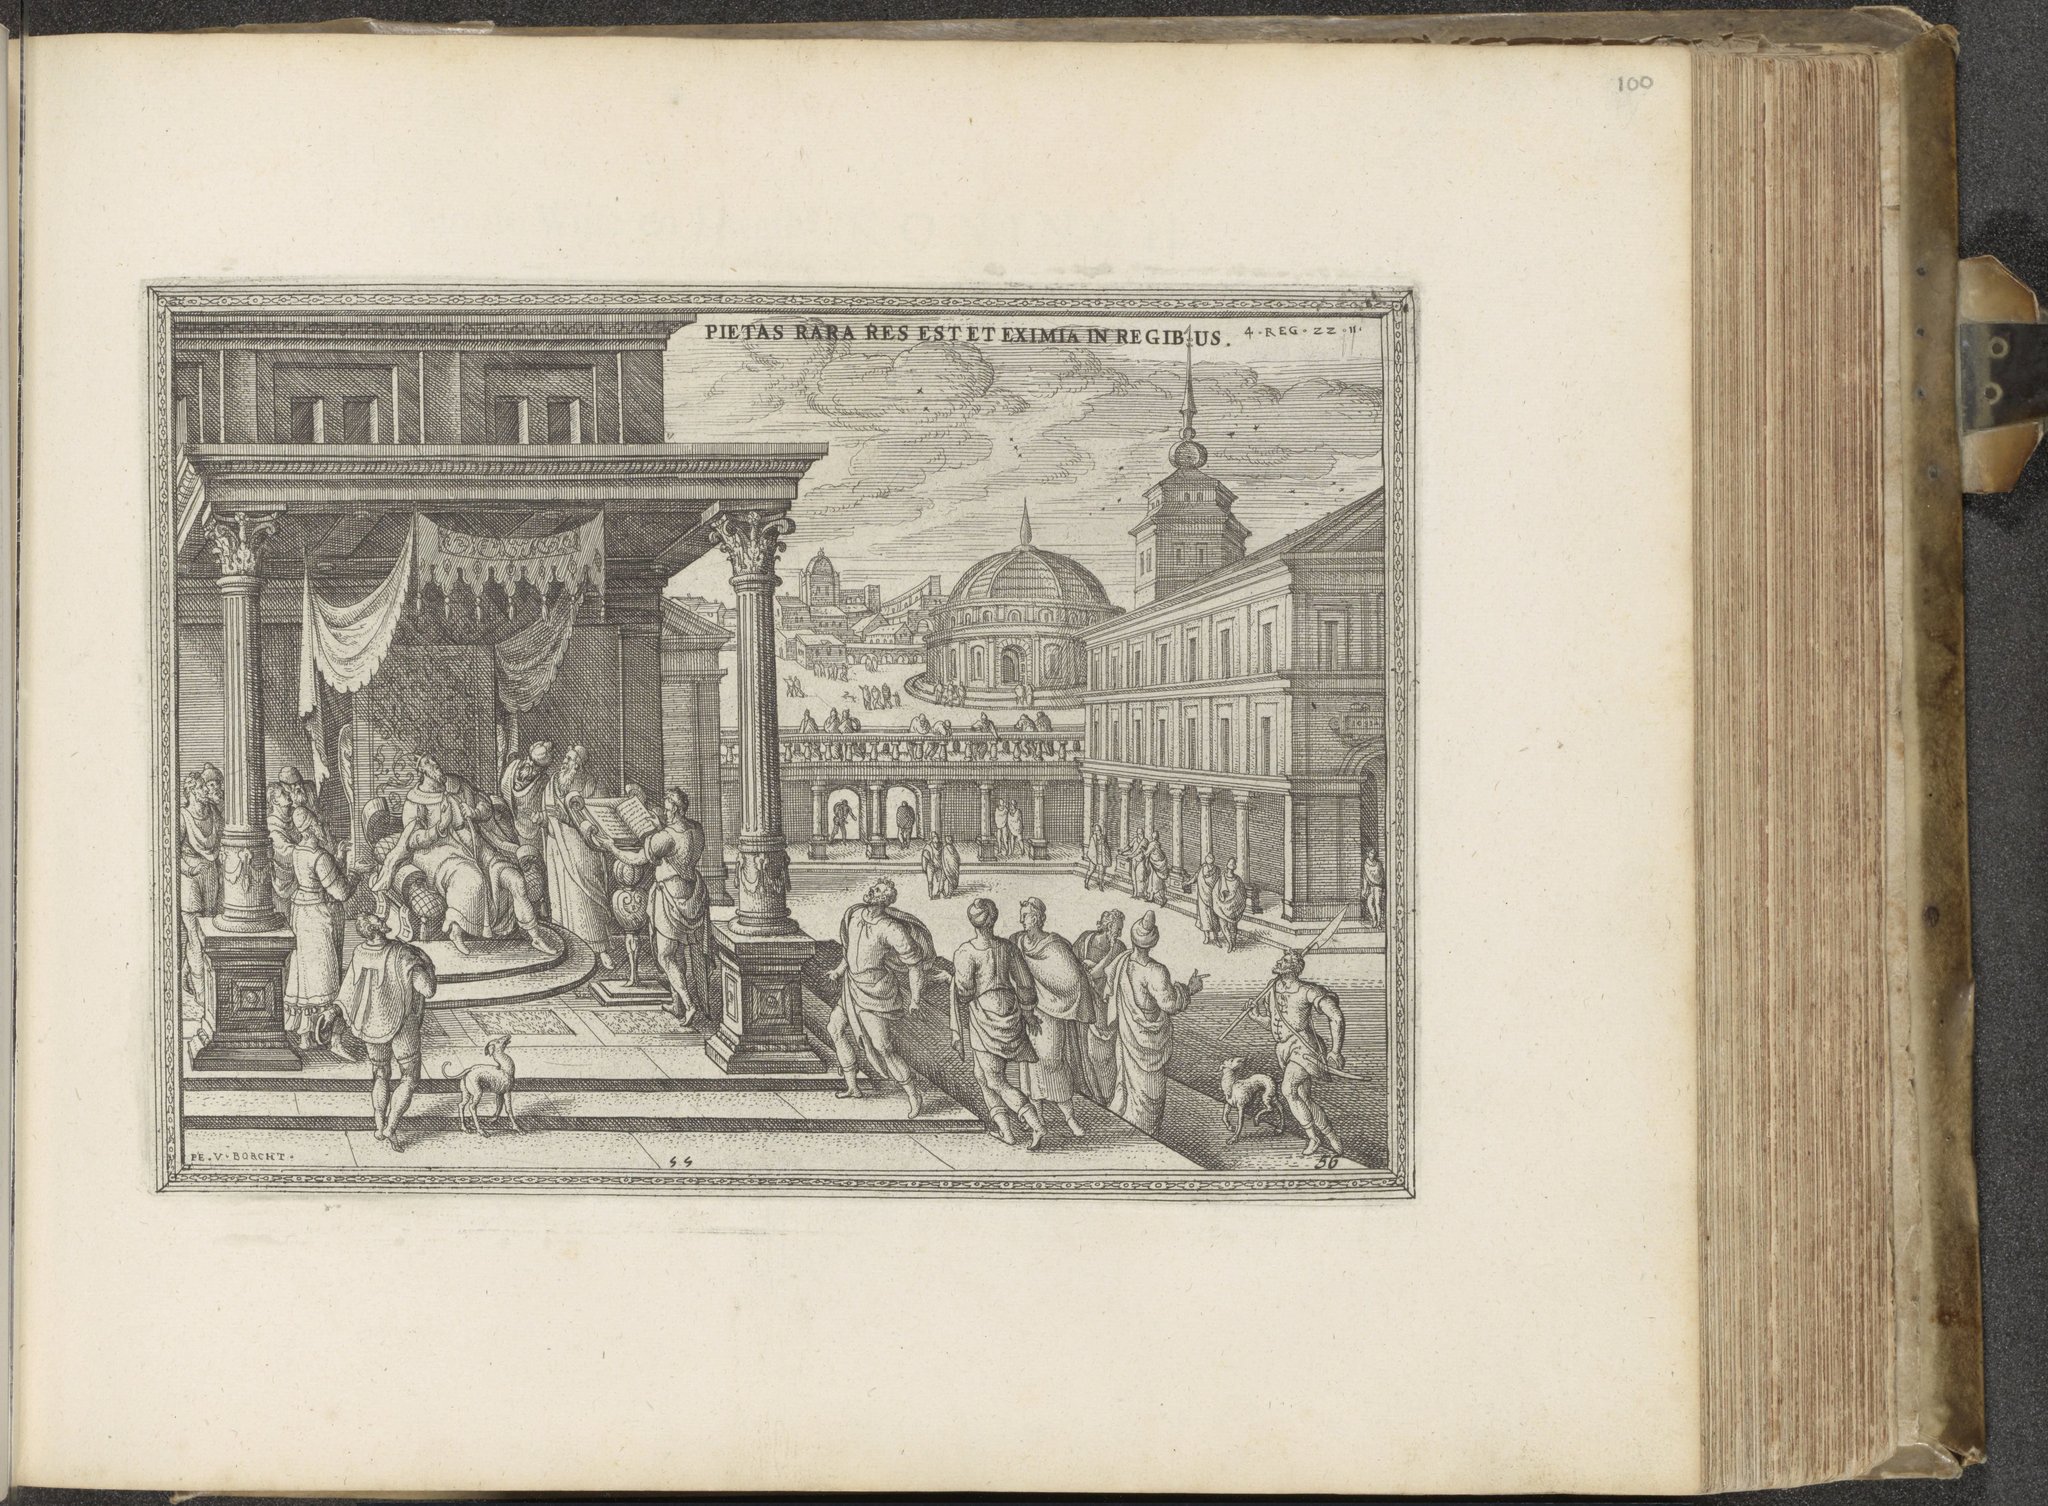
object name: album leaf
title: Koning Josia scheurt zijn kleren bij het horen van de woorden uit het wetboek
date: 1582-1593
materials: paper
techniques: etching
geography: amsterdam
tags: saphan reads the book of law aloud to the king who tears his clothes in dismay, old testament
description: Koning Josia zit op zijn troon onder een baldakijn en omgeven door leden van zijn hof. Naast hem leest zijn hofschrijver Safia voor uit het wetboek op de lezenaar. Bij het horen van de woorden van Safia scheurt de koning zijn mantel (2. Kon. 22:11). Rechts een ander deel van het paleis en een muur met twee poorten. In de verte een koepel. De prent maakt deel uit van een album.